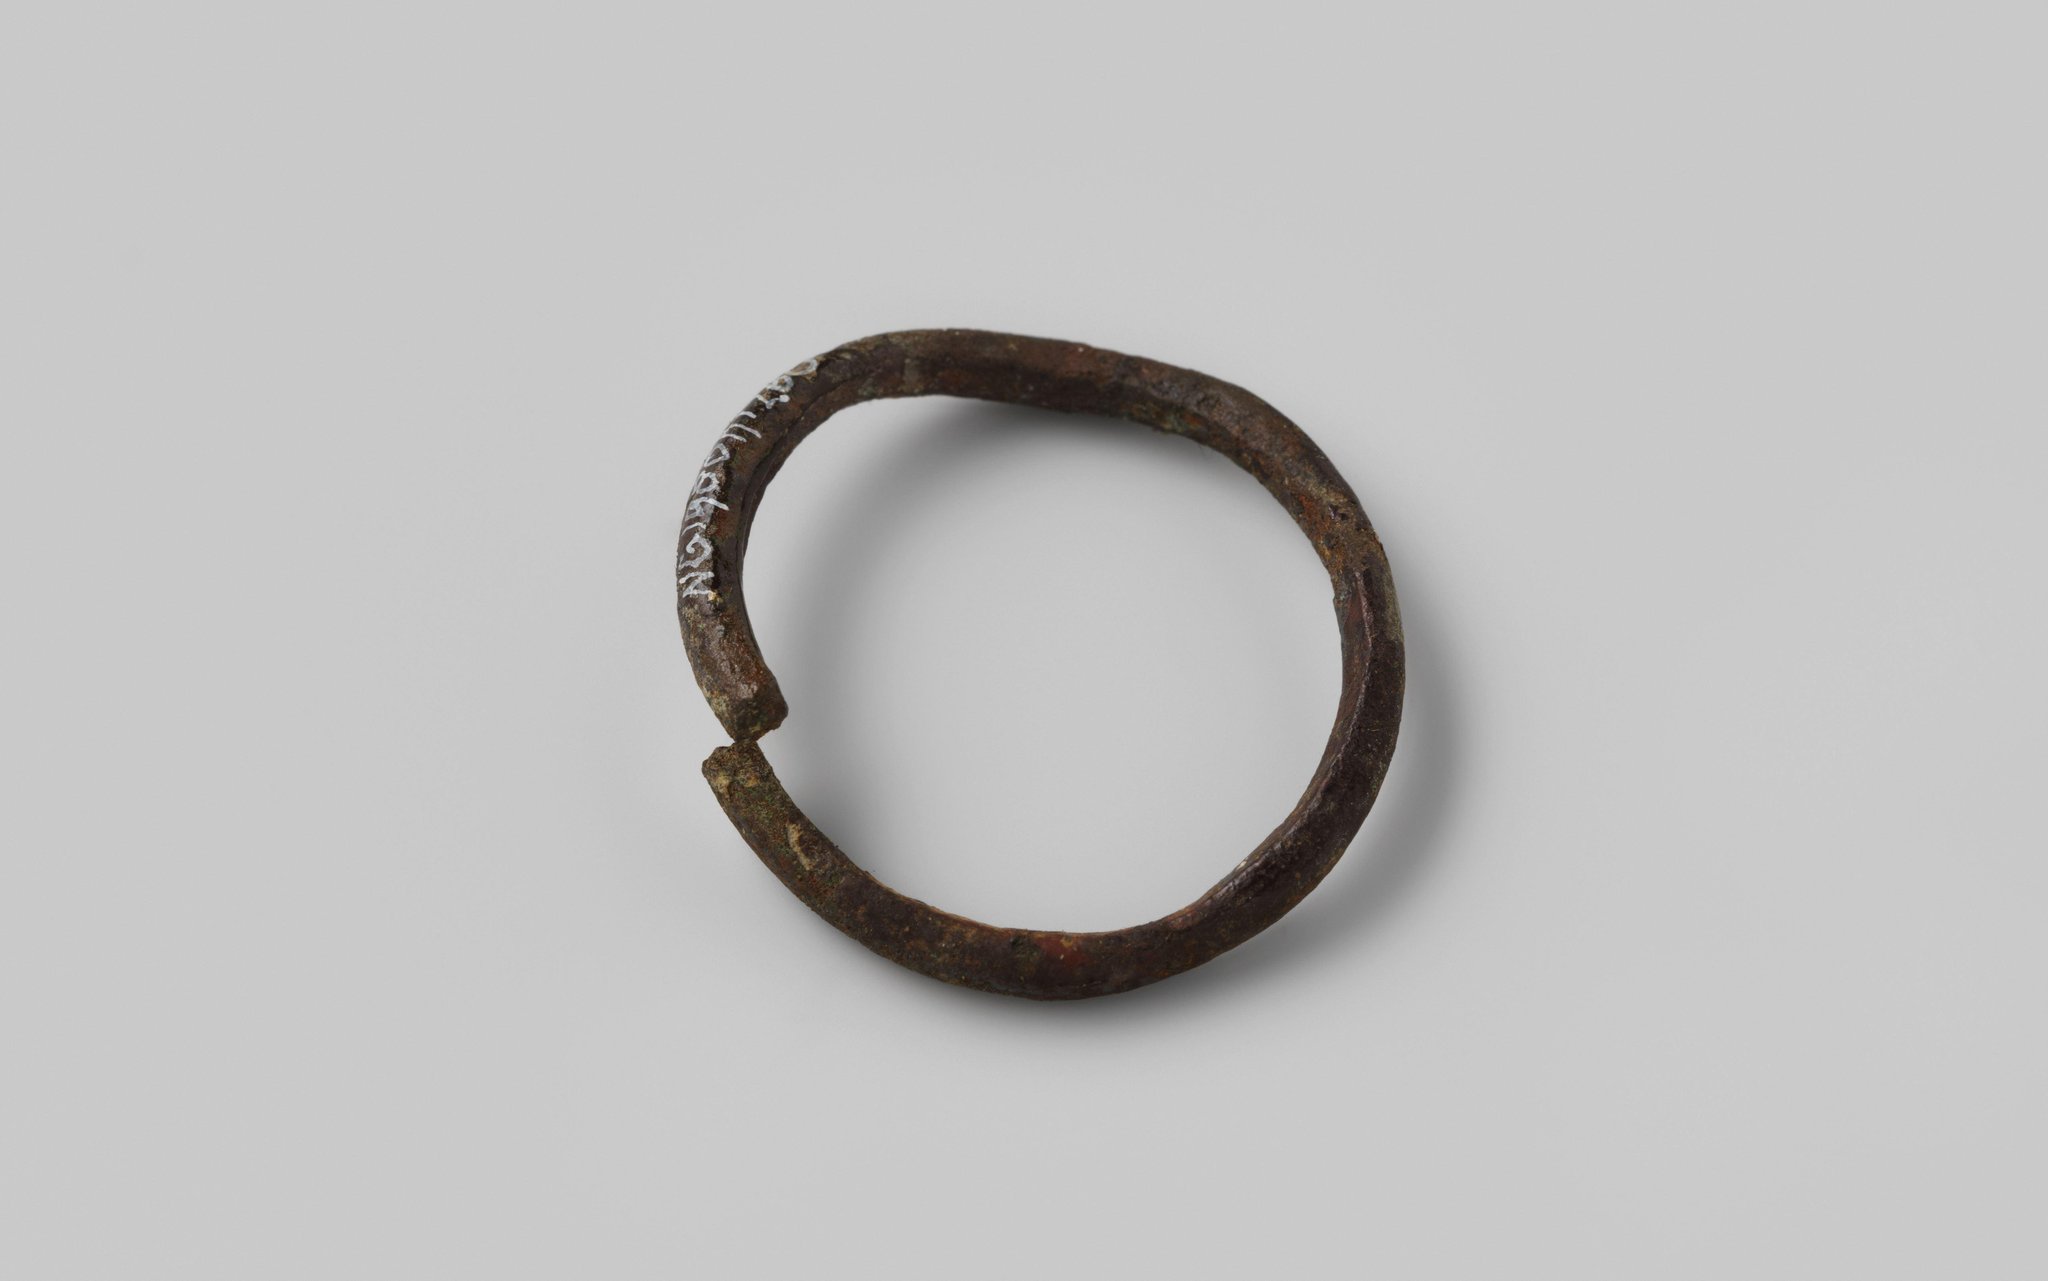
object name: ring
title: Ringvormig fragment uit het wrak van de Oost-Indiëvaarder Hollandia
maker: Anonymous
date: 1700-1743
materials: copper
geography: netherlands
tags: verenigde oostindische compagnie, hollandia (schip), annet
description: Varied parts or fragments, rings or ring-shaped fragments; id. 80H946.